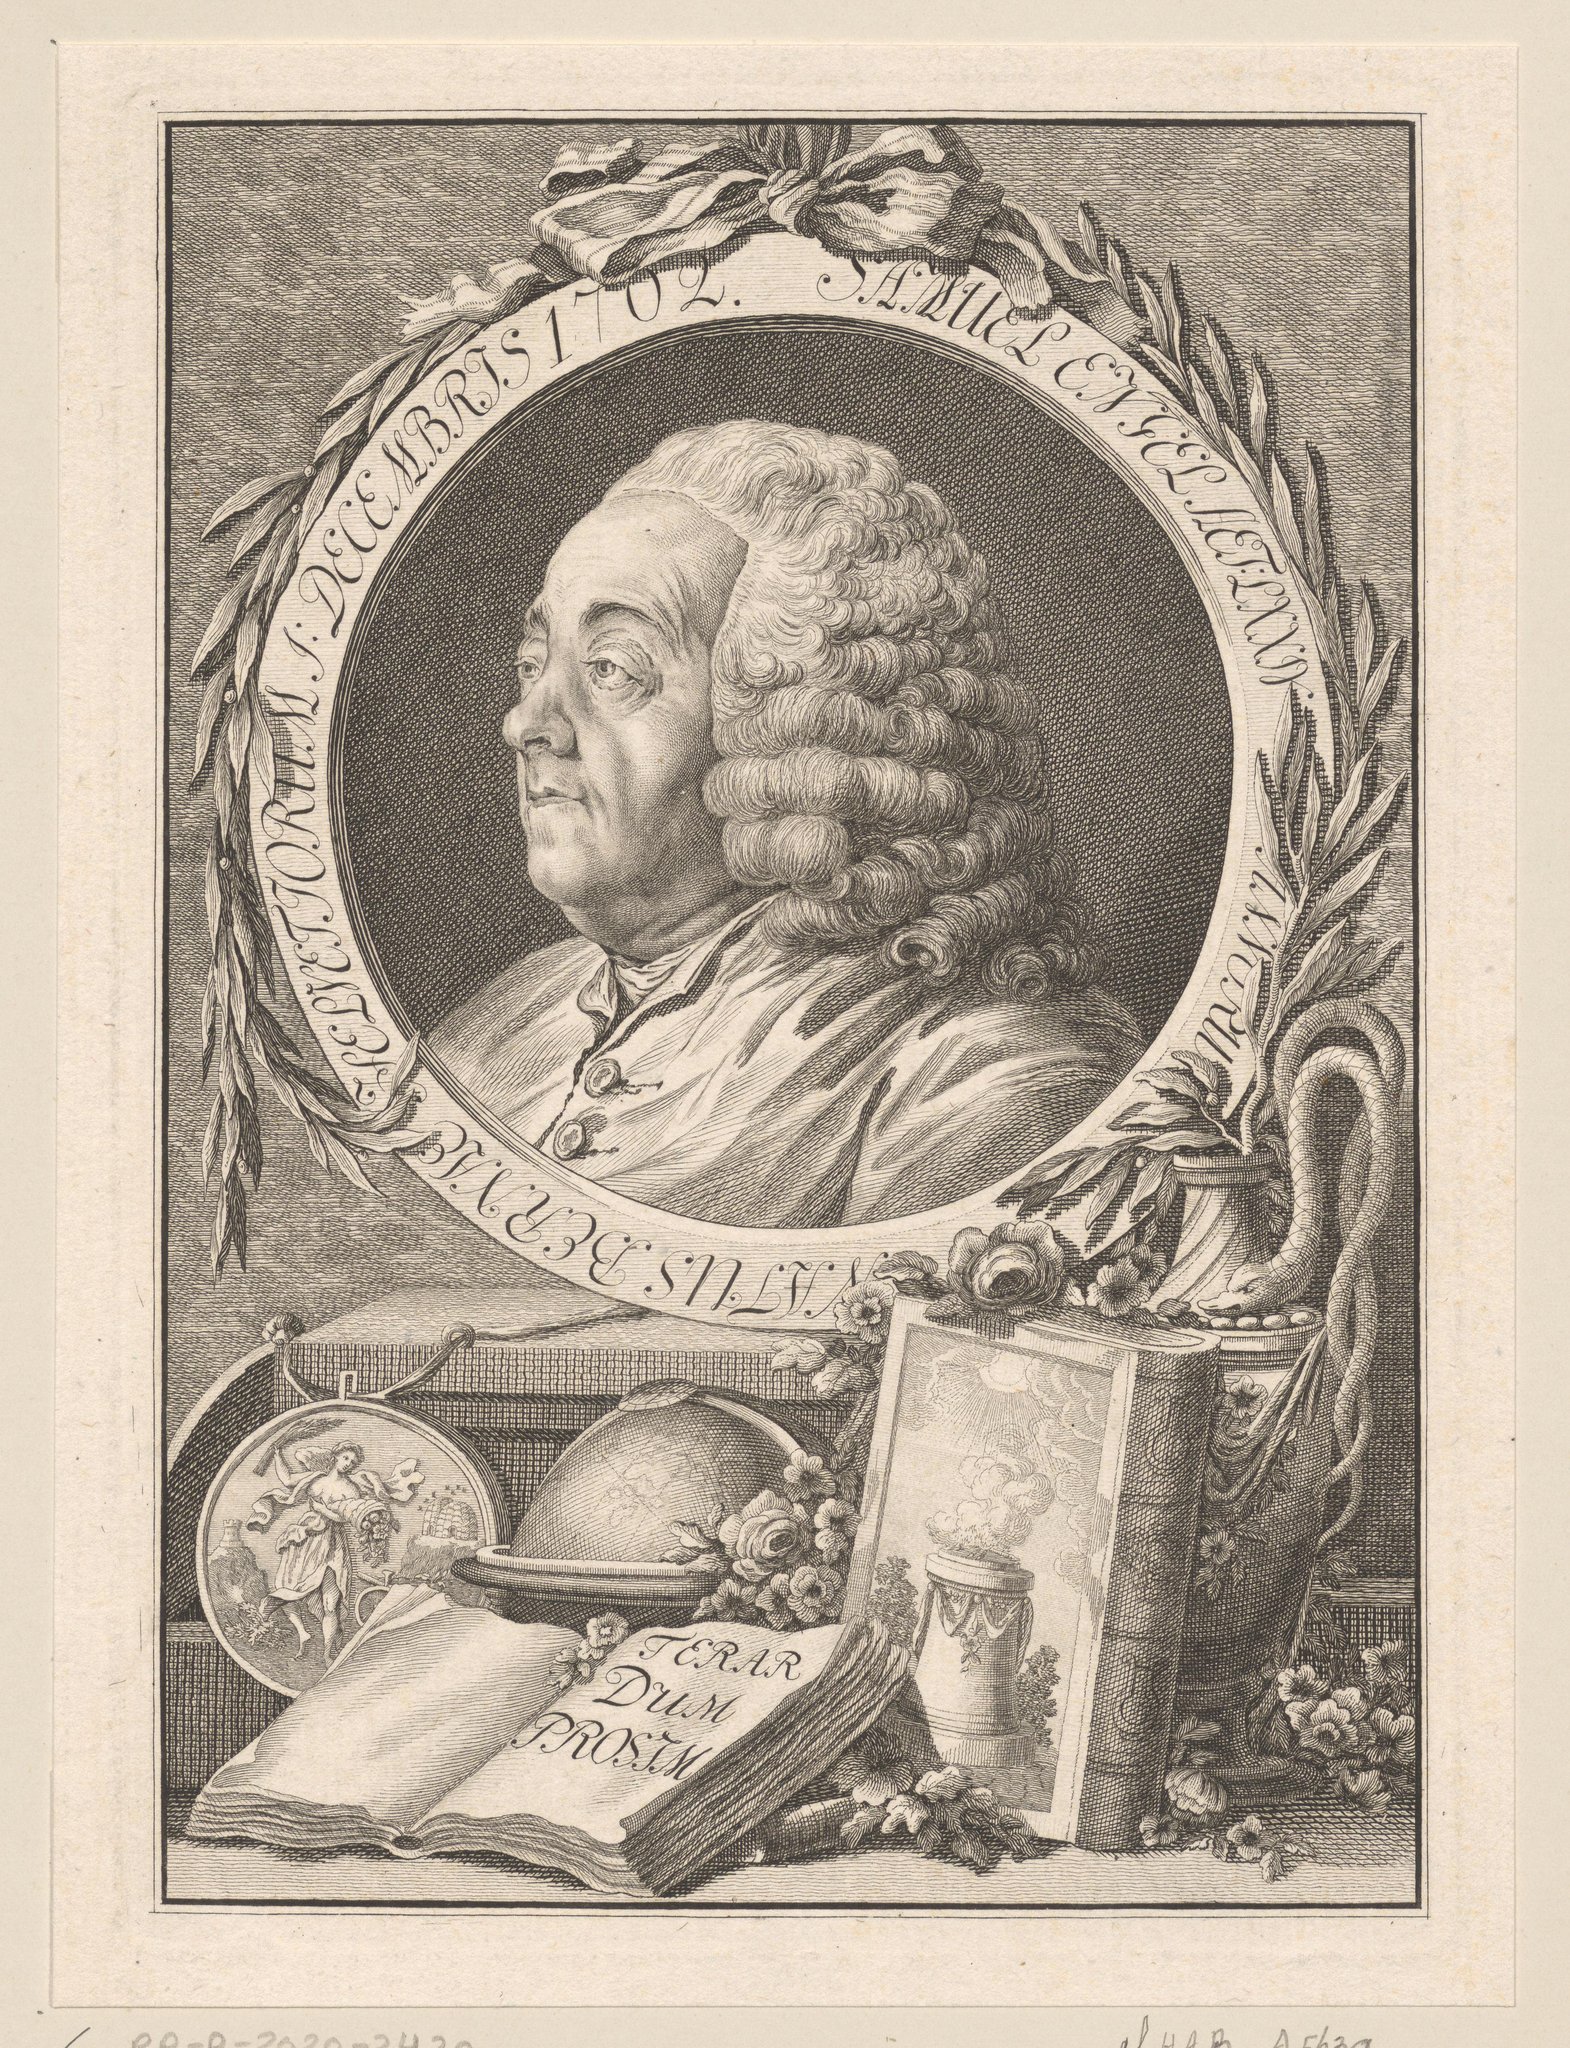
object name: print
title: Portret van Samuel Engel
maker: balthasar anton dunker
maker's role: draughtsman, print maker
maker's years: 1746-1807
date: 1776-1778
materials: paper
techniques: etching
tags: snakes, 'cornucopia', horn of plenty, historical persons, book - mm - book open, politician, e.g. party leader, globe